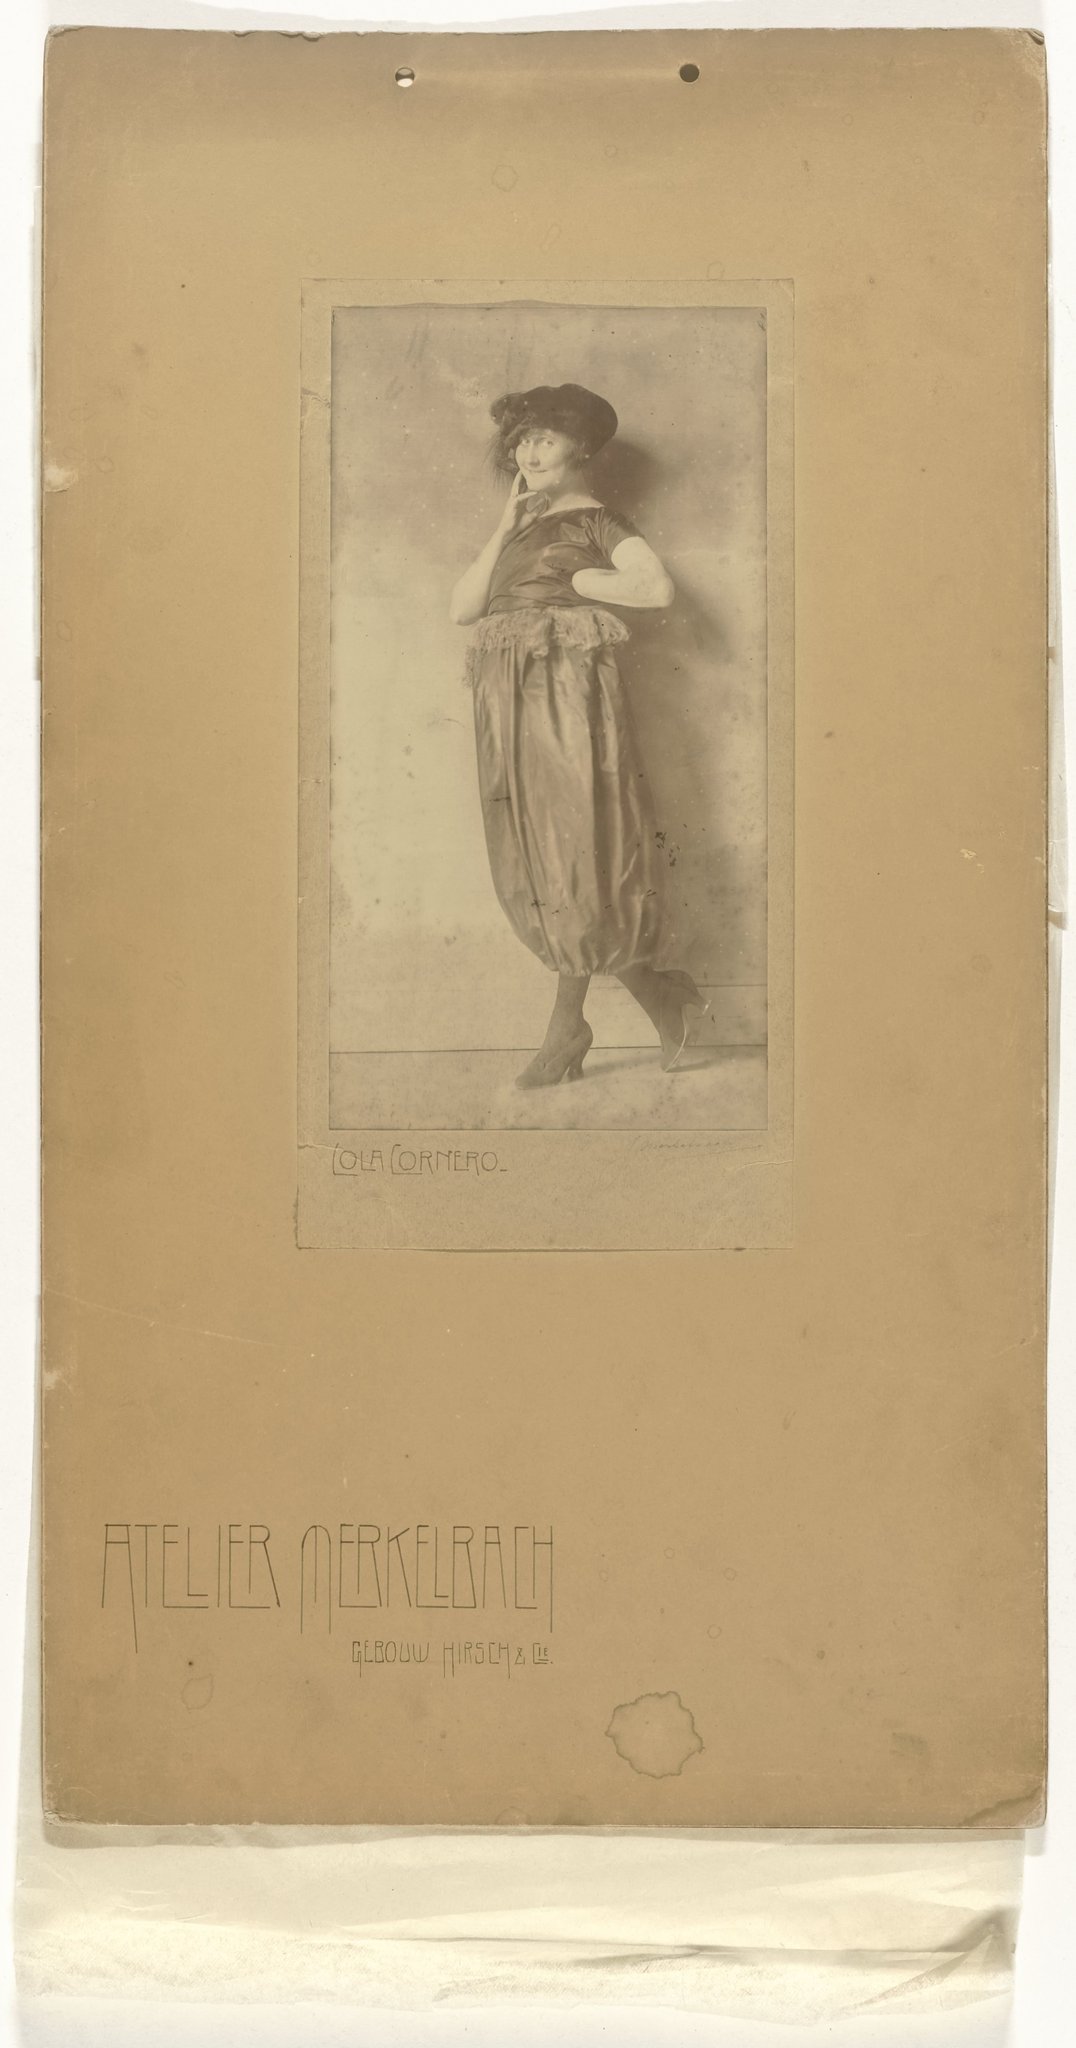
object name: photograph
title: Portret van actrice Lola Cornero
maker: jacob merkelbach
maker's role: fotograaf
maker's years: 1877-1942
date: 1913-1930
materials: cardboard, photographic support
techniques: collodion silver print, daylight paper print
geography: amsterdam